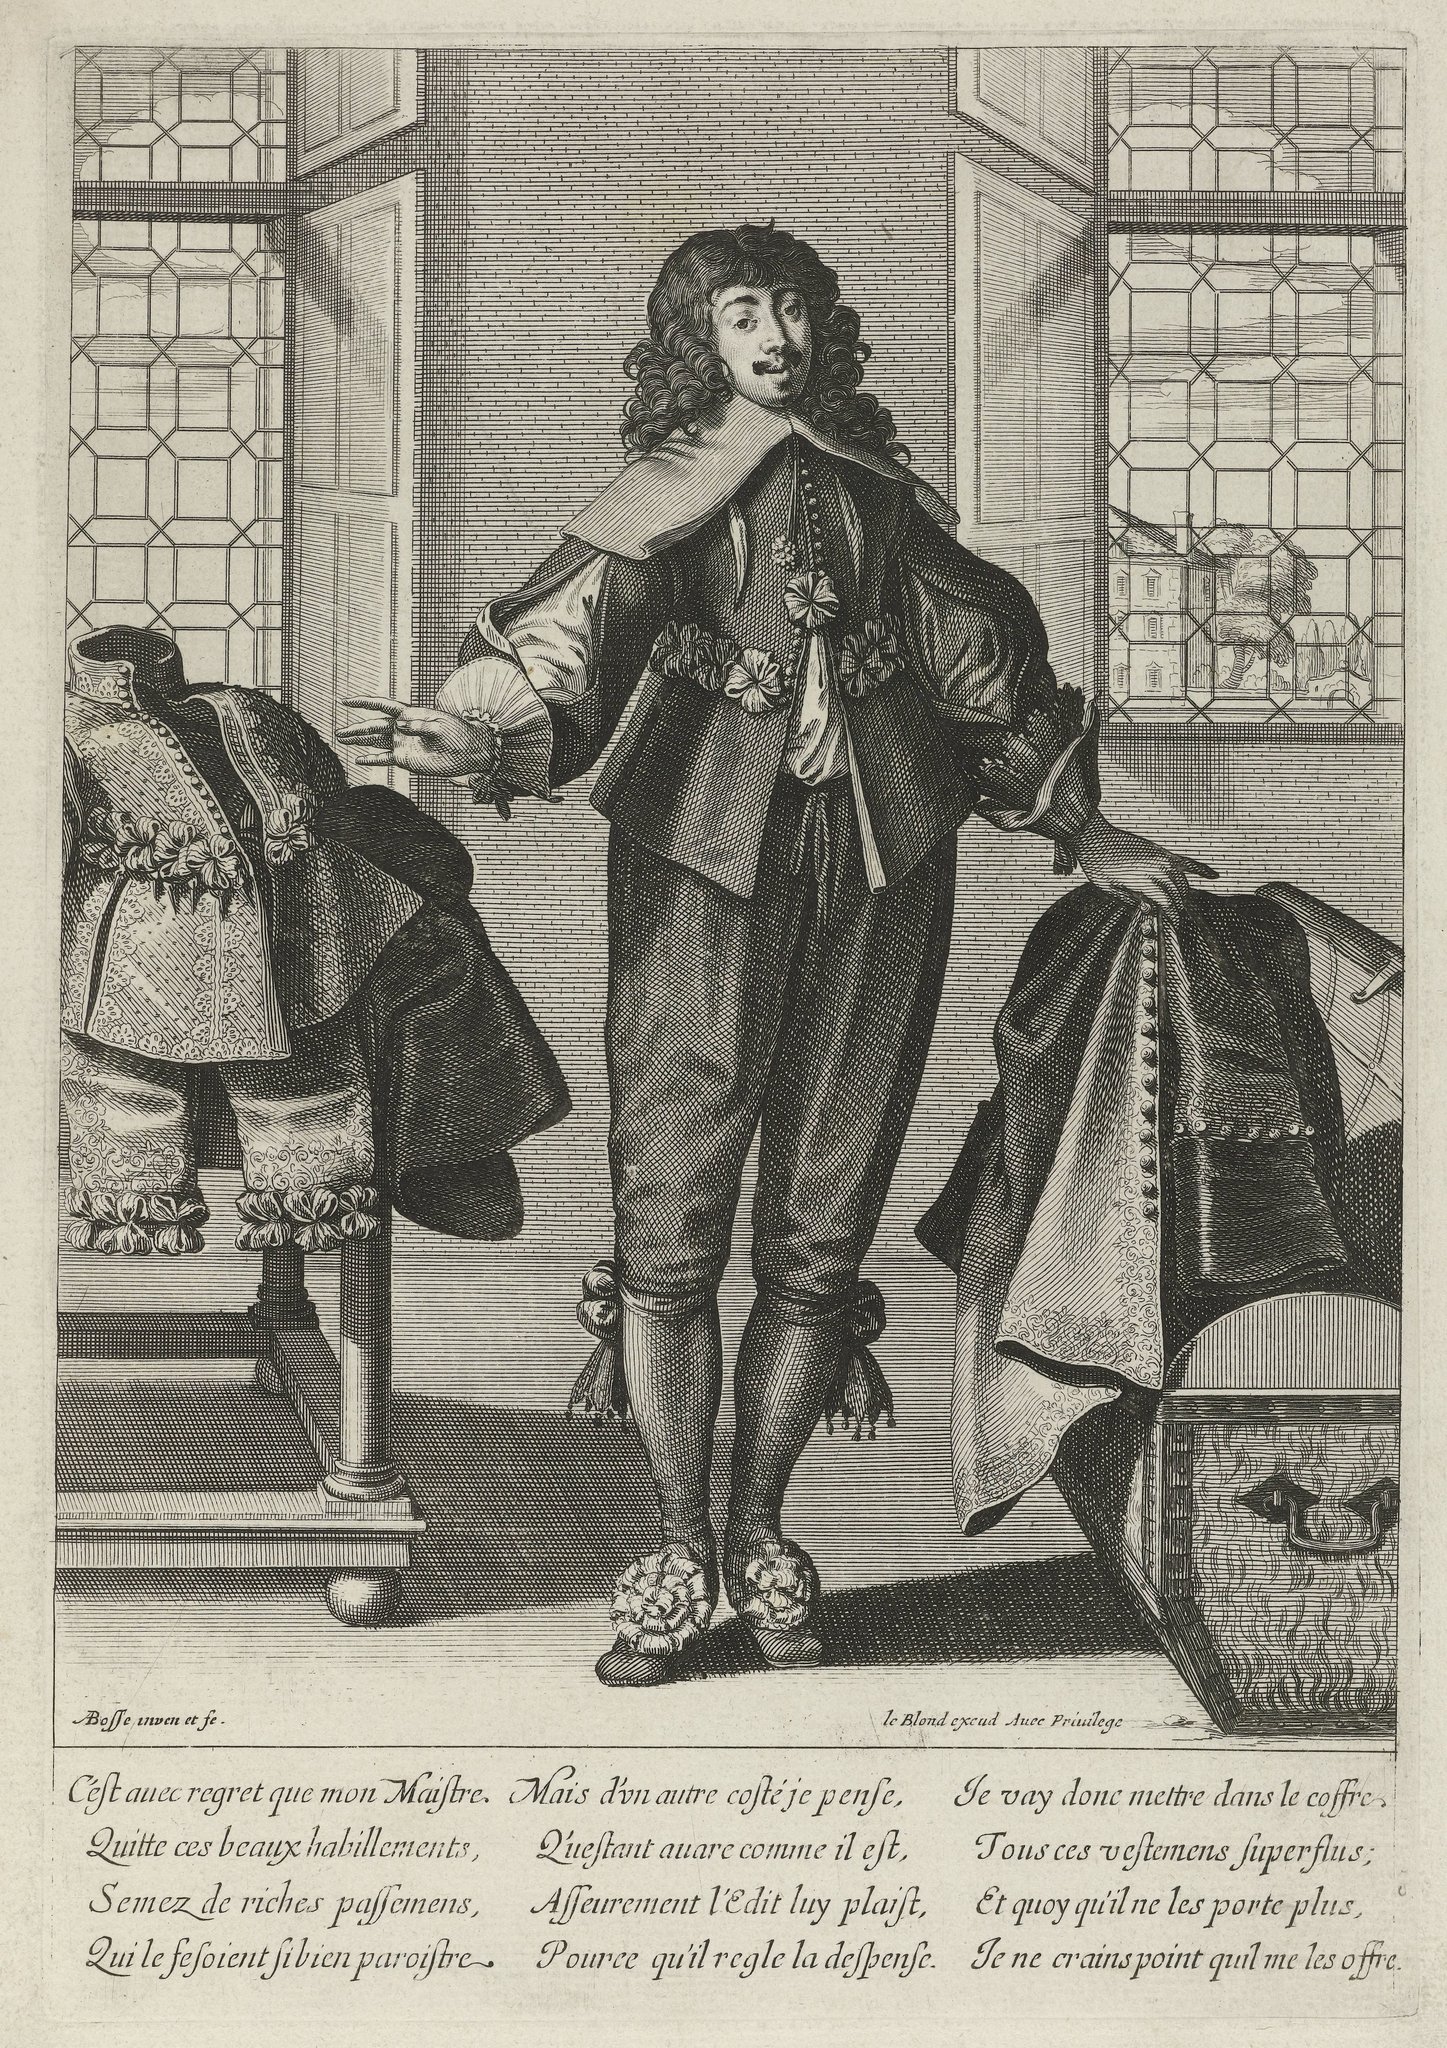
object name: costume print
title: Navolging van het edict van 1633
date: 1633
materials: paper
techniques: engraving, etching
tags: border, ribbon, braid (+ men's clothes), coat (+ men's clothes), moustache, shoes, sandals (+ men's clothes), clothes, costume (+ men's clothes), chest, coffer, neck-gear: collar (+ men's clothes), trousers, breeches, etc. (breeches) (+ men's clothes), clothing for the upper part of the body (doublet) (+ men's clothes), stockings, socks (+ men's clothes), sleeves (+ men's clothes), manservant, footman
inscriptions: caption: ‘C'est avec regret que mon maistre / Quitte ces beaux habillements / Semez de riches passemens / Qui le fesoient si bien paroistre. / Mais d'un autre costé je pense / Qu'estant avare comme il est / Assurement l'edit luy plaist / Pour ce qu'il regle la despense / Je vay donc mettre dans le coffre / Tous ces vestemens superflus / Et quoy qu'il ne les porte plus / Je ne crains point qu'il me les offre.’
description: In een vertrek staat een lakei naast een kledingkist waarin hij de mantel van zijn meester opbergt. Het edict van 1633 verbood het dragen van te luxueuze kleding. De lakei draagt een jas versierd met strikken, de mouwen van zijn hemd hebben brede, dubbele manchetten en op zijn schoenen zitten grote rozetten. Op de tafel liggen de wambuis en kniebroek van zijn meester die, net als de mantel, opgeborgen zullen worden in de kledingkist.